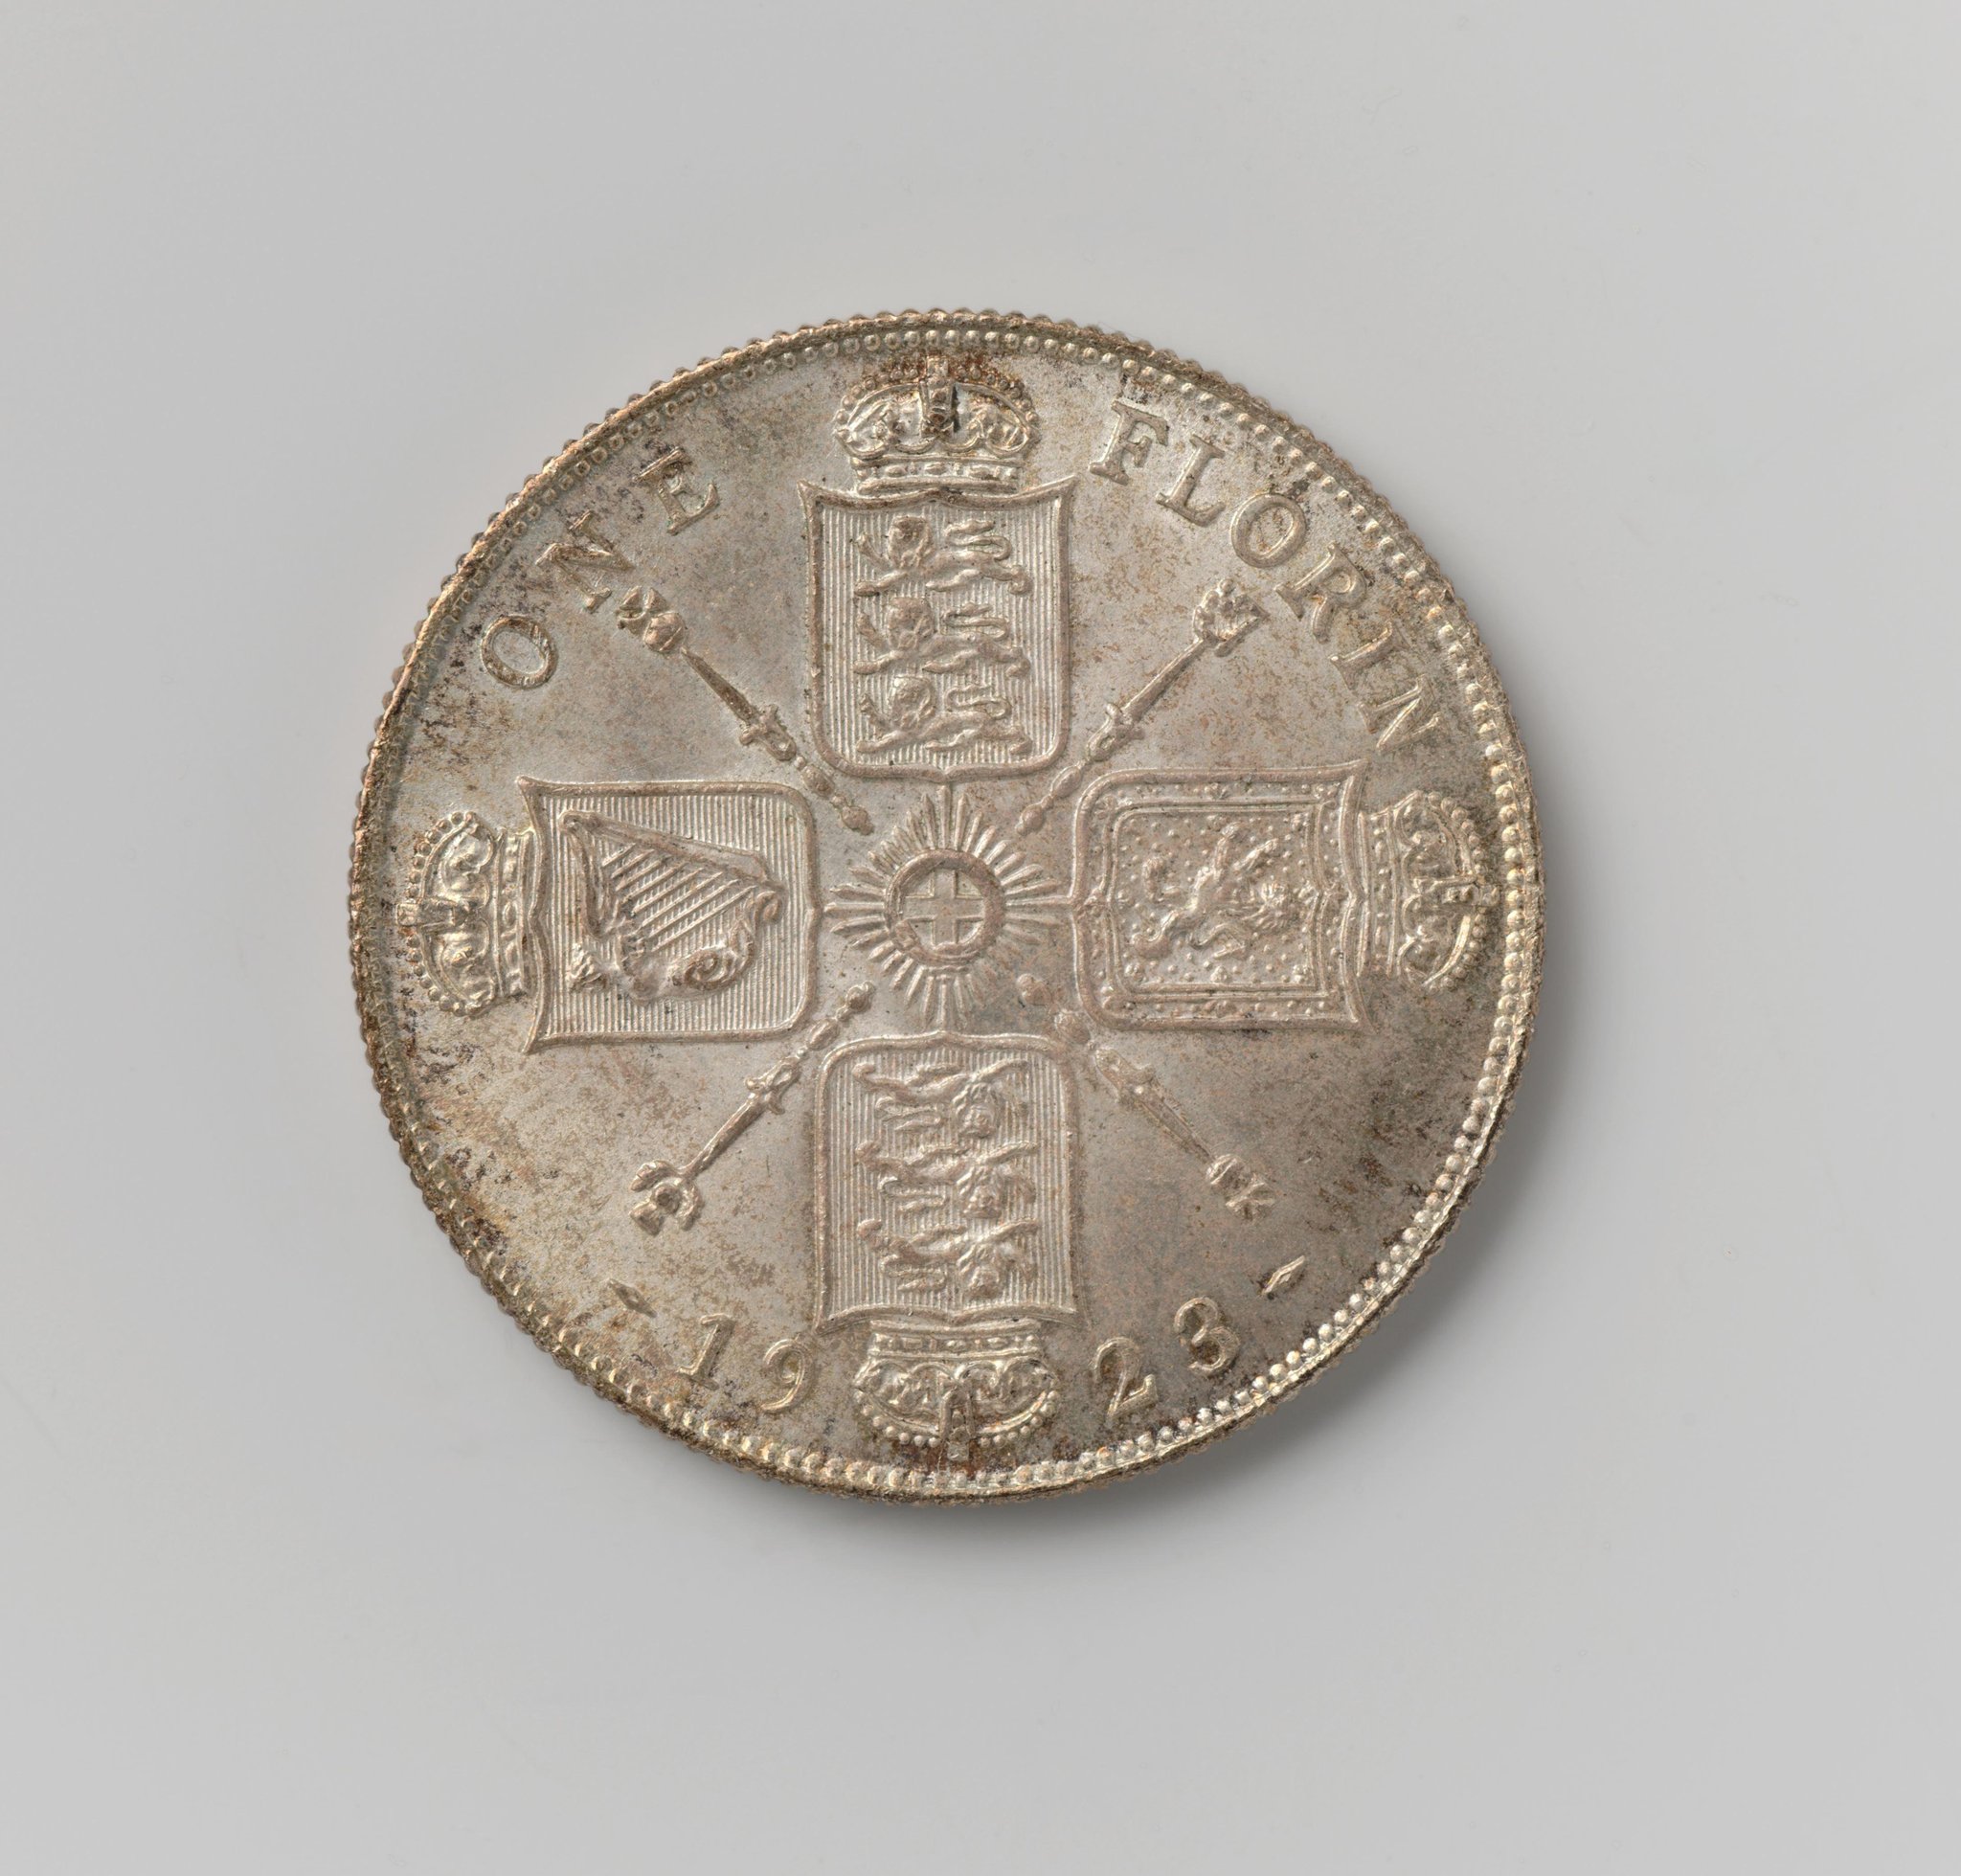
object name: florin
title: Engeland, George V, florin, 1923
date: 1923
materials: silver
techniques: striking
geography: london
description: Zilveren munt. Voorzijde: hoofd van de koning naar links. Keerzijde: tussen twee gekruiste scepters vier gekroonde wapenschilden. In het hart door stralen omgeven cirkel, waarin kruis. Als omschrift waarde-aanduiding. Jaartal onderaan. Kartelrand.